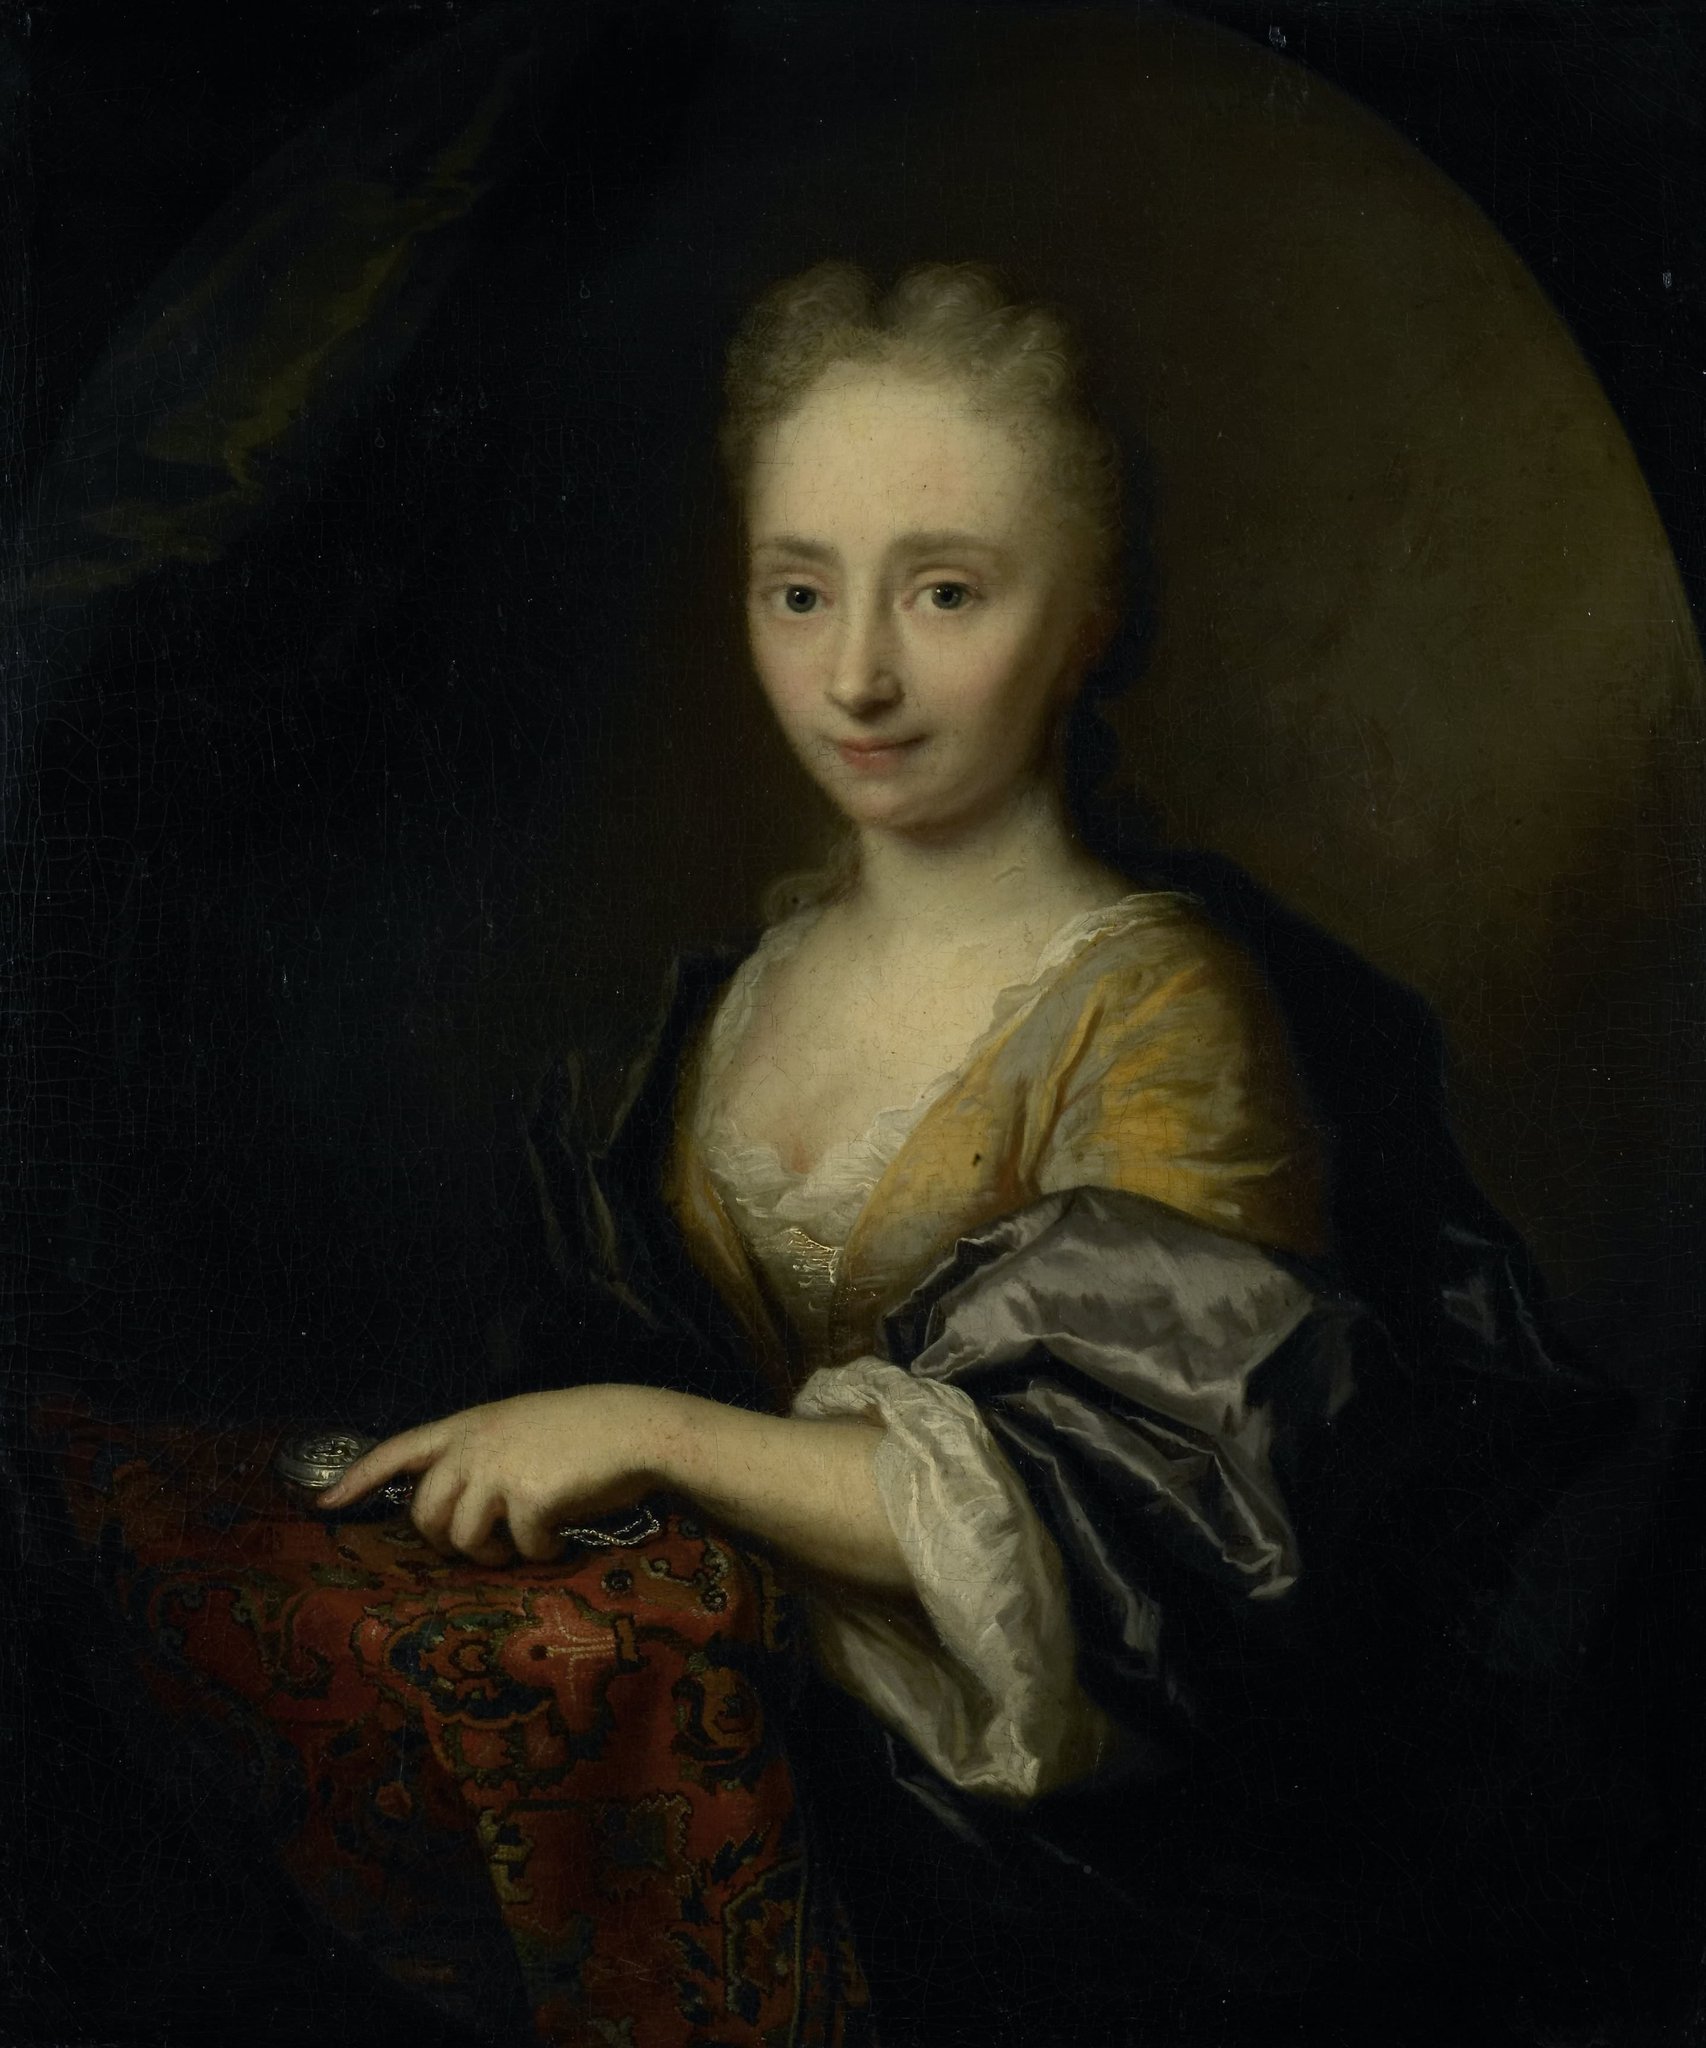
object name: painting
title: Portrait of a Woman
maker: arnold boonen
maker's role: draughtsman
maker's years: 1669-1729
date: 1690-1729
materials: canvas, oil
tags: adult woman, historical persons not known by name - bb - woman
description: Portret van een vrouw, zittend aan een tafel. In de hand een horloge. Pendant van SK-A-1914.